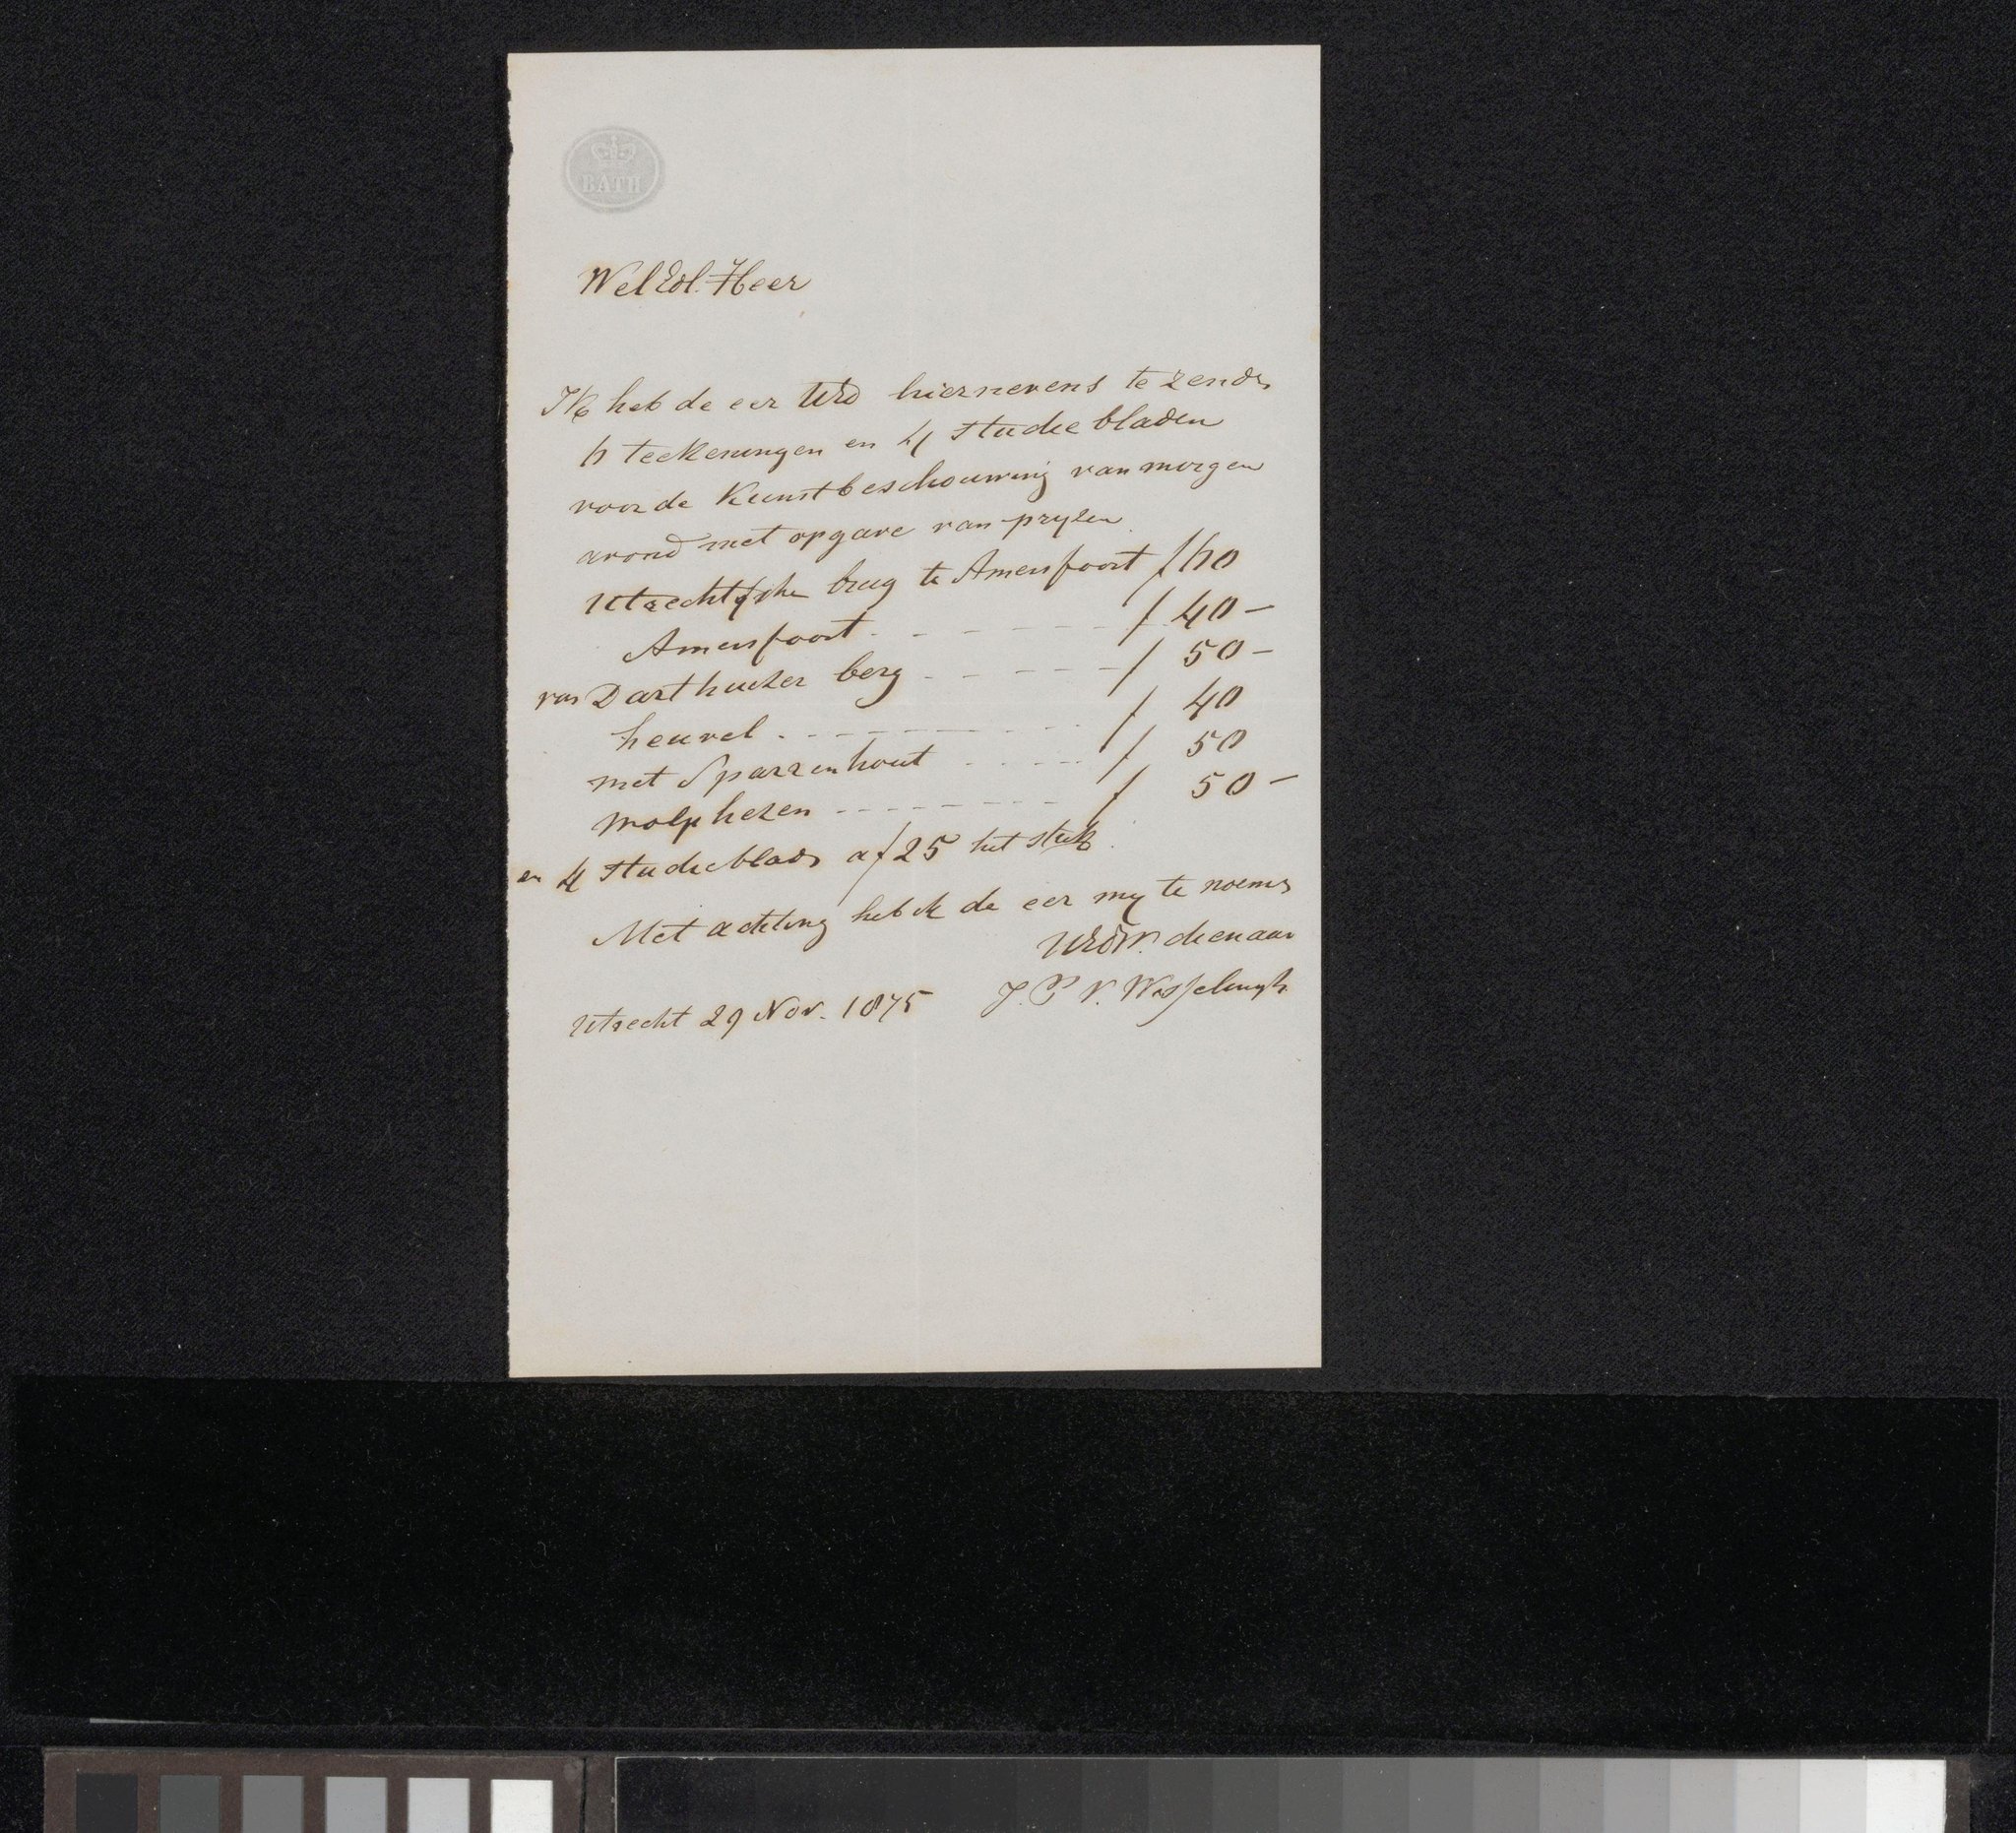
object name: letter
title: Brief aan anoniem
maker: johannes pieter van wisselingh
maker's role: draughtsman, painter, print maker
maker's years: 1812-1899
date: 1875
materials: ink, paper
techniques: pen, writing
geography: utrecht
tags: criticizing and discussing art, art criticism, drawing, money